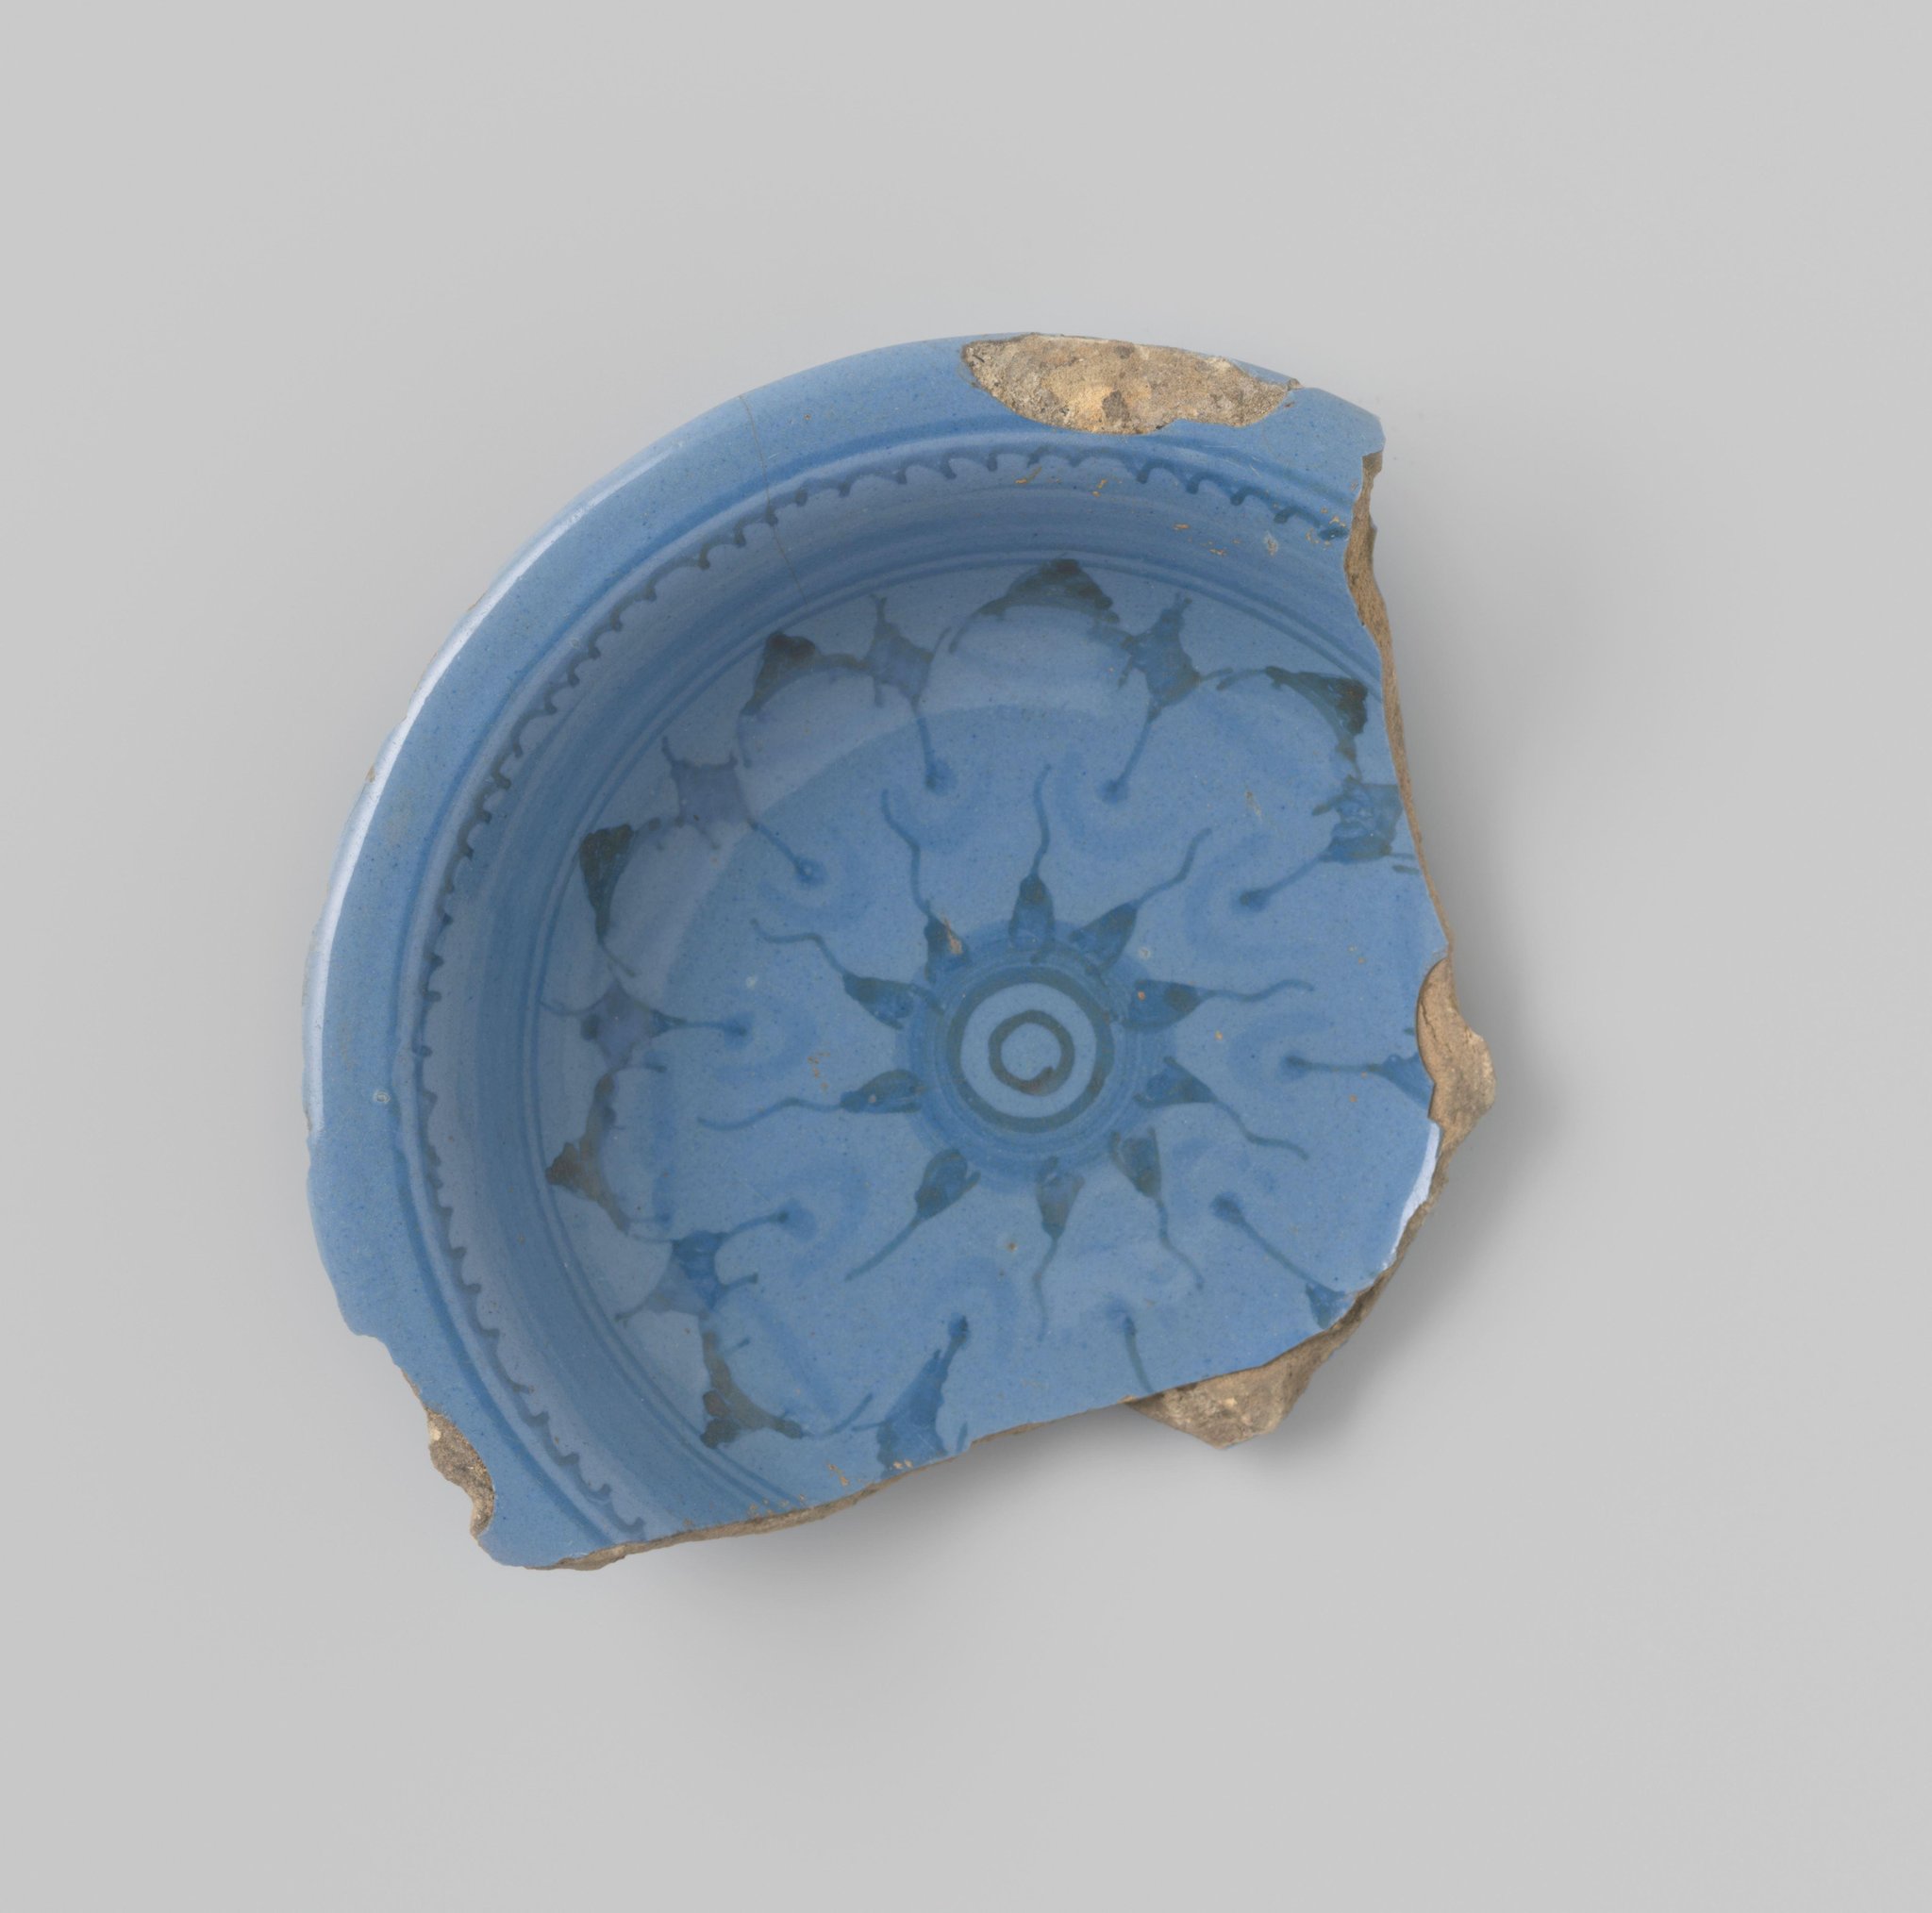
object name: sherd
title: Schotelscherf van geelbakkend aardewerk, voorzien van blauw glazuur aan de boven- en onderzijde, waarop een gestileerde schildering van een bloem op het plat, en strepen en gegolfde randjes op de rand, en op de achterzijde een patroon van halve cirkels in blauw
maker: Anonymous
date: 1500-1699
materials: earthenware, glaze